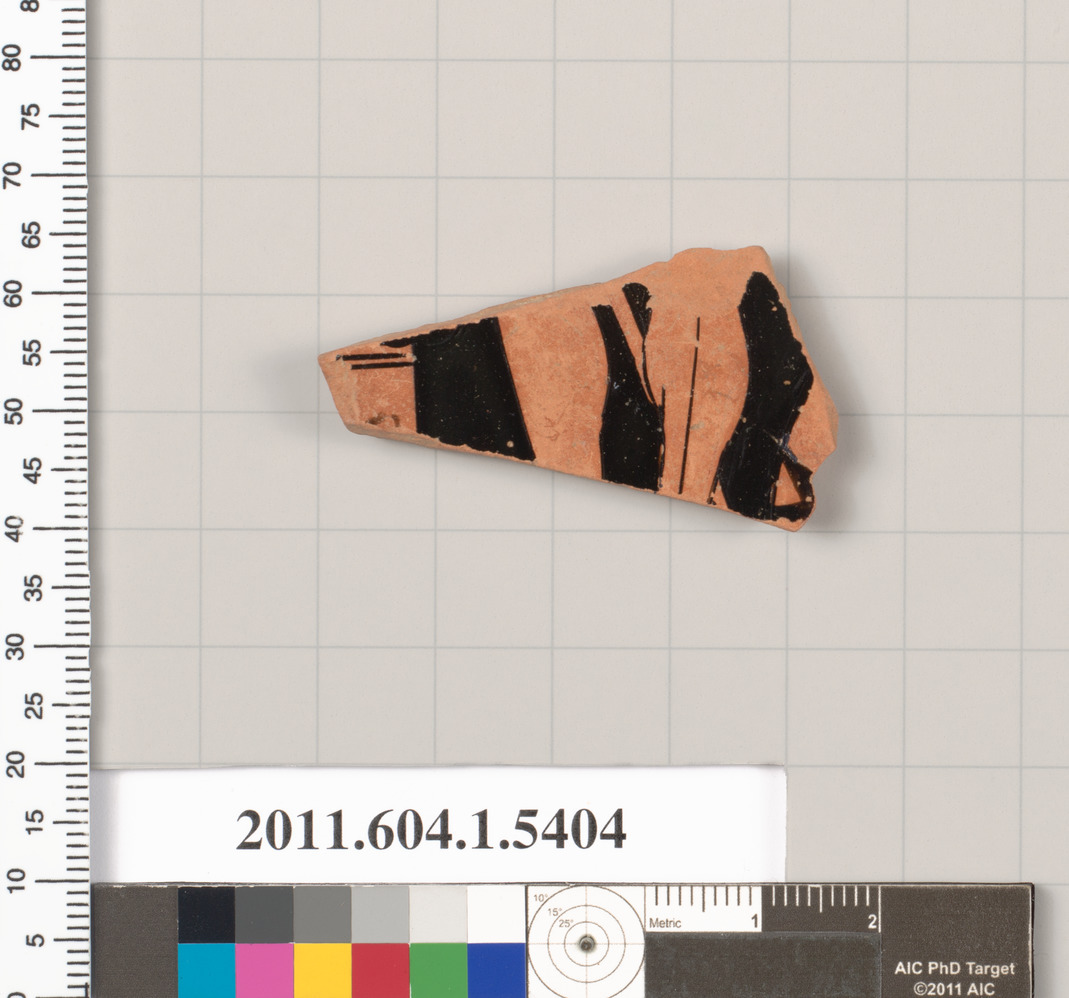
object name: kylix fragment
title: Terracotta fragment of a kylix (drinking cup)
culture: greek, attic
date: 500-480 BCE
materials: terracotta